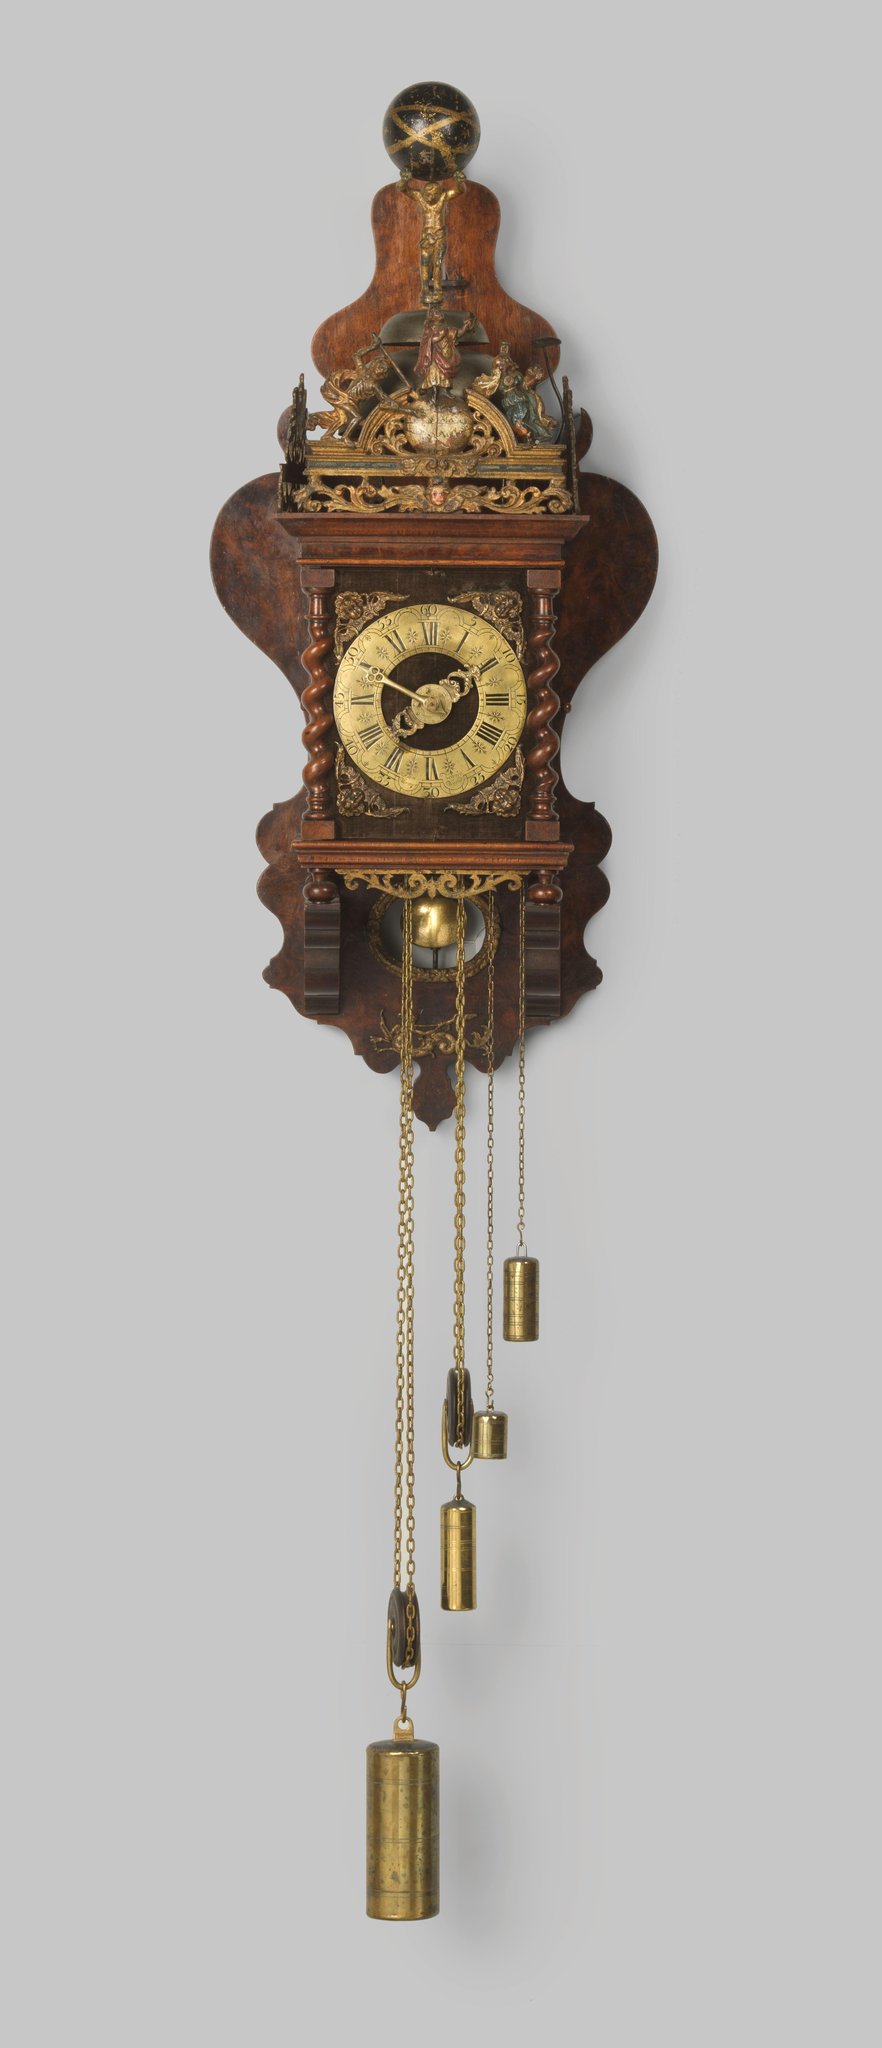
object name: clockwork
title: Wandklok met geprofileerde voet- en kroonlijst en geslingerde hoekstijlen, tegen een vaasvormig blad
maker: jan koogies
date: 1700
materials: brass, glass, iron, metal, wood, velvet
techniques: casting, cutting, engraving, polychromy, sawing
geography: wormerveer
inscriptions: signature: ‘Jan Koogies, Wormerveer’